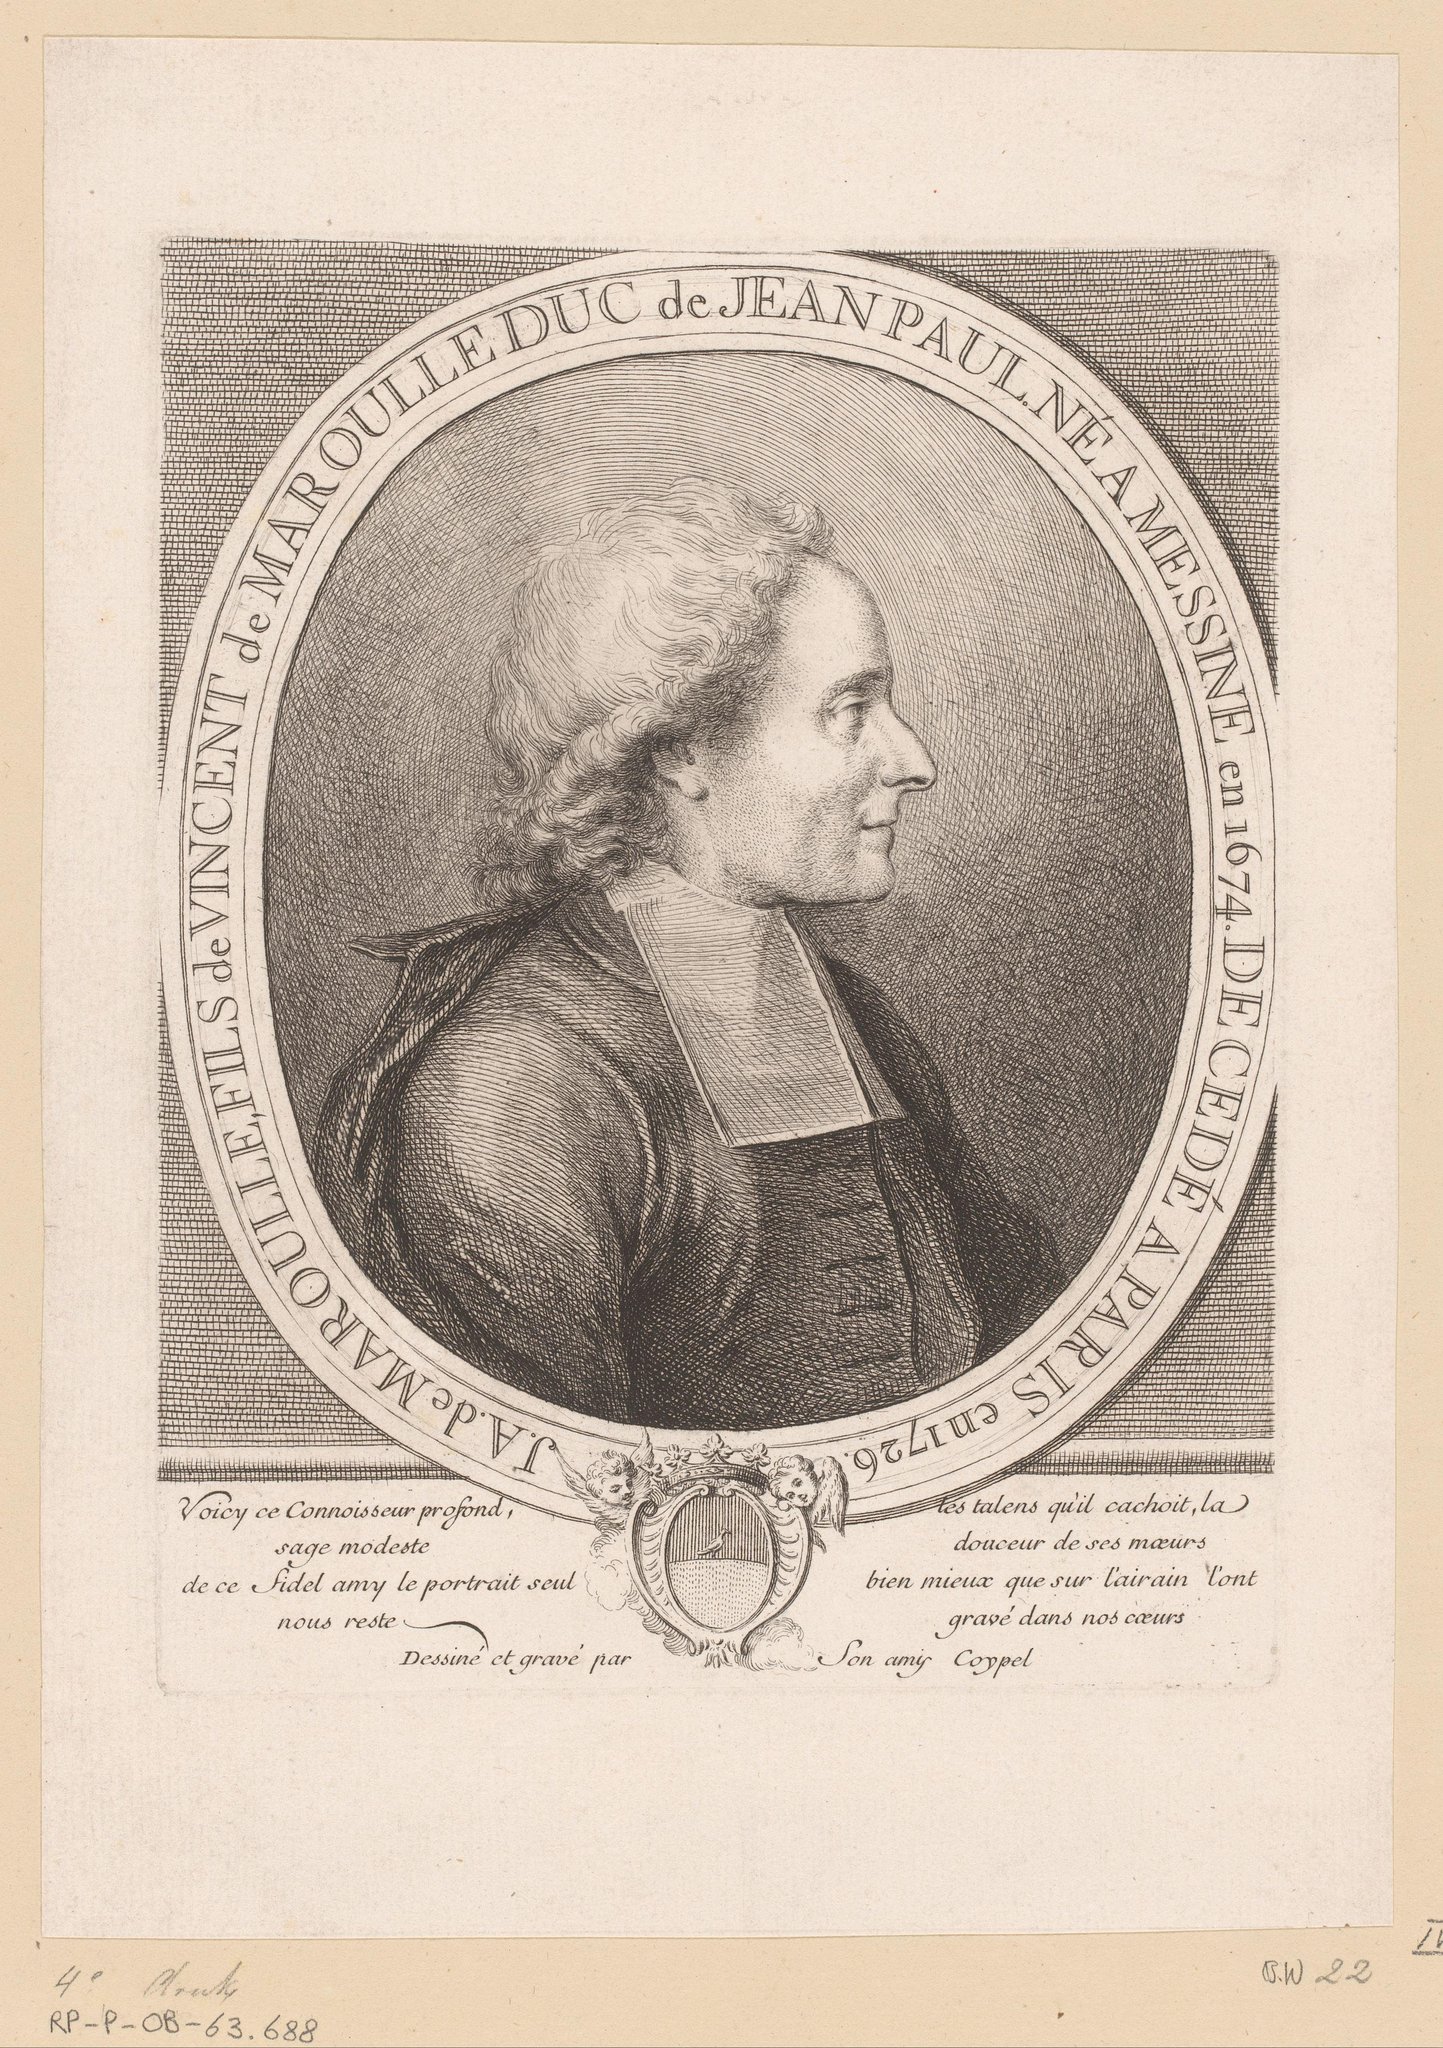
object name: print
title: Portret van Jean Antoine de Maroulle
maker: charles-antoine coypel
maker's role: painter, print maker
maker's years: 1694-1752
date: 1726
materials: paper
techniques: etching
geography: france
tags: paris, jean antoine de maroulle, historical persons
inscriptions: collector's mark: Lugt 240